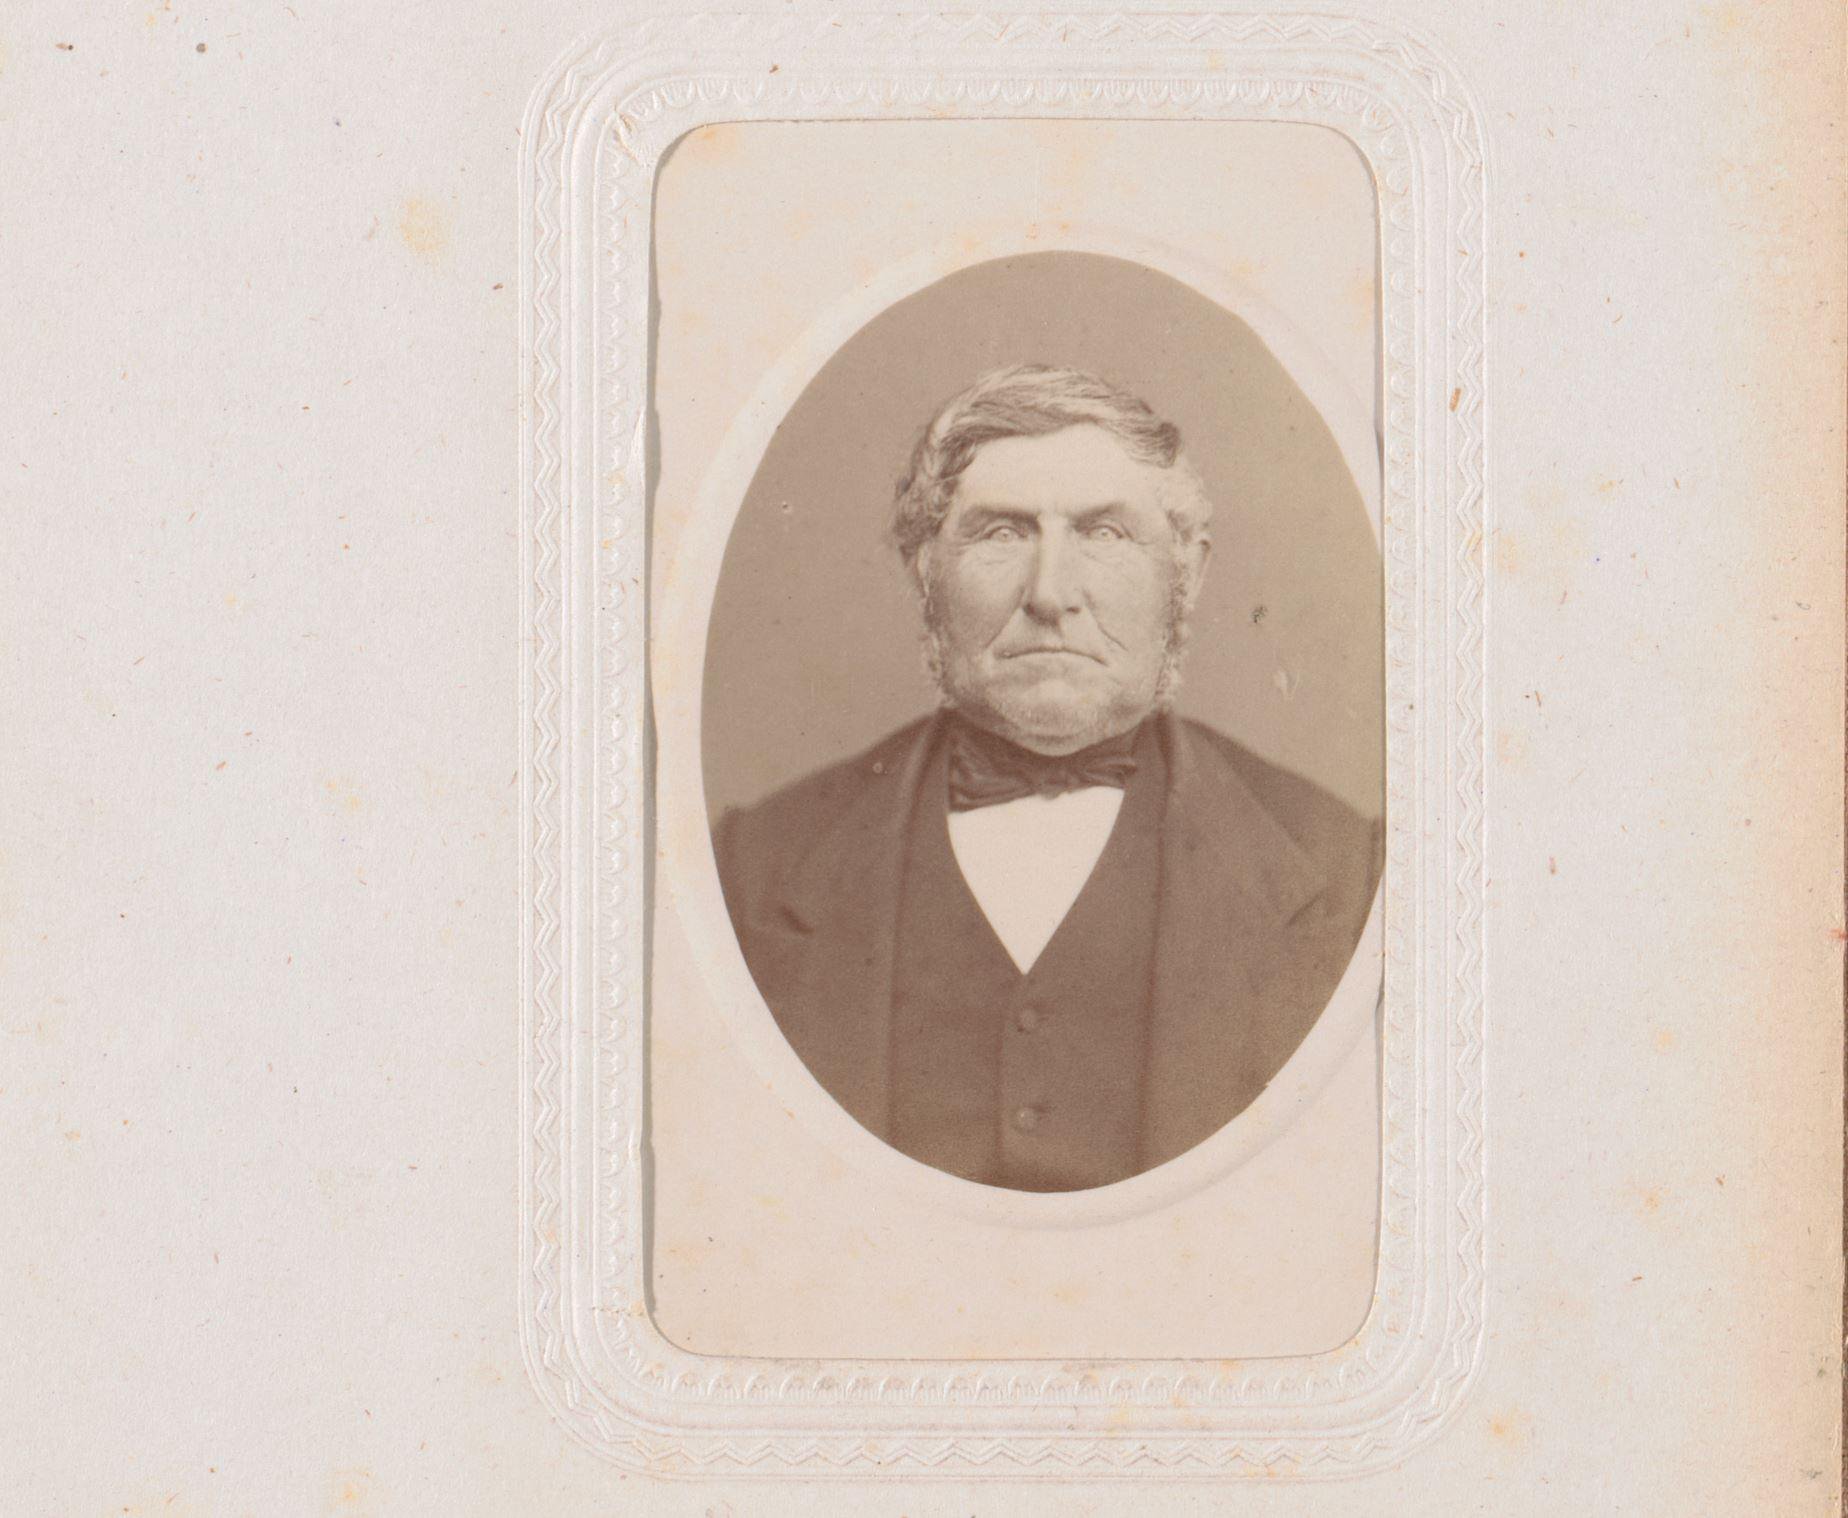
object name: photograph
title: Portret van een man, aangeduid als C.A. de Jong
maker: kornelis willem schorteldoek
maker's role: boekbinder, fotograaf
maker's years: 1800-1885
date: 1855-1885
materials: cardboard, photographic support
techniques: albumen print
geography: gorinchem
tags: historical persons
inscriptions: name: ‘de Jong’, inscription: ‘SCHORTELDOEK/ PHOTOGRAAF/ Gorinchem./ Groote Markt’, name: ‘C. A. de Jong’